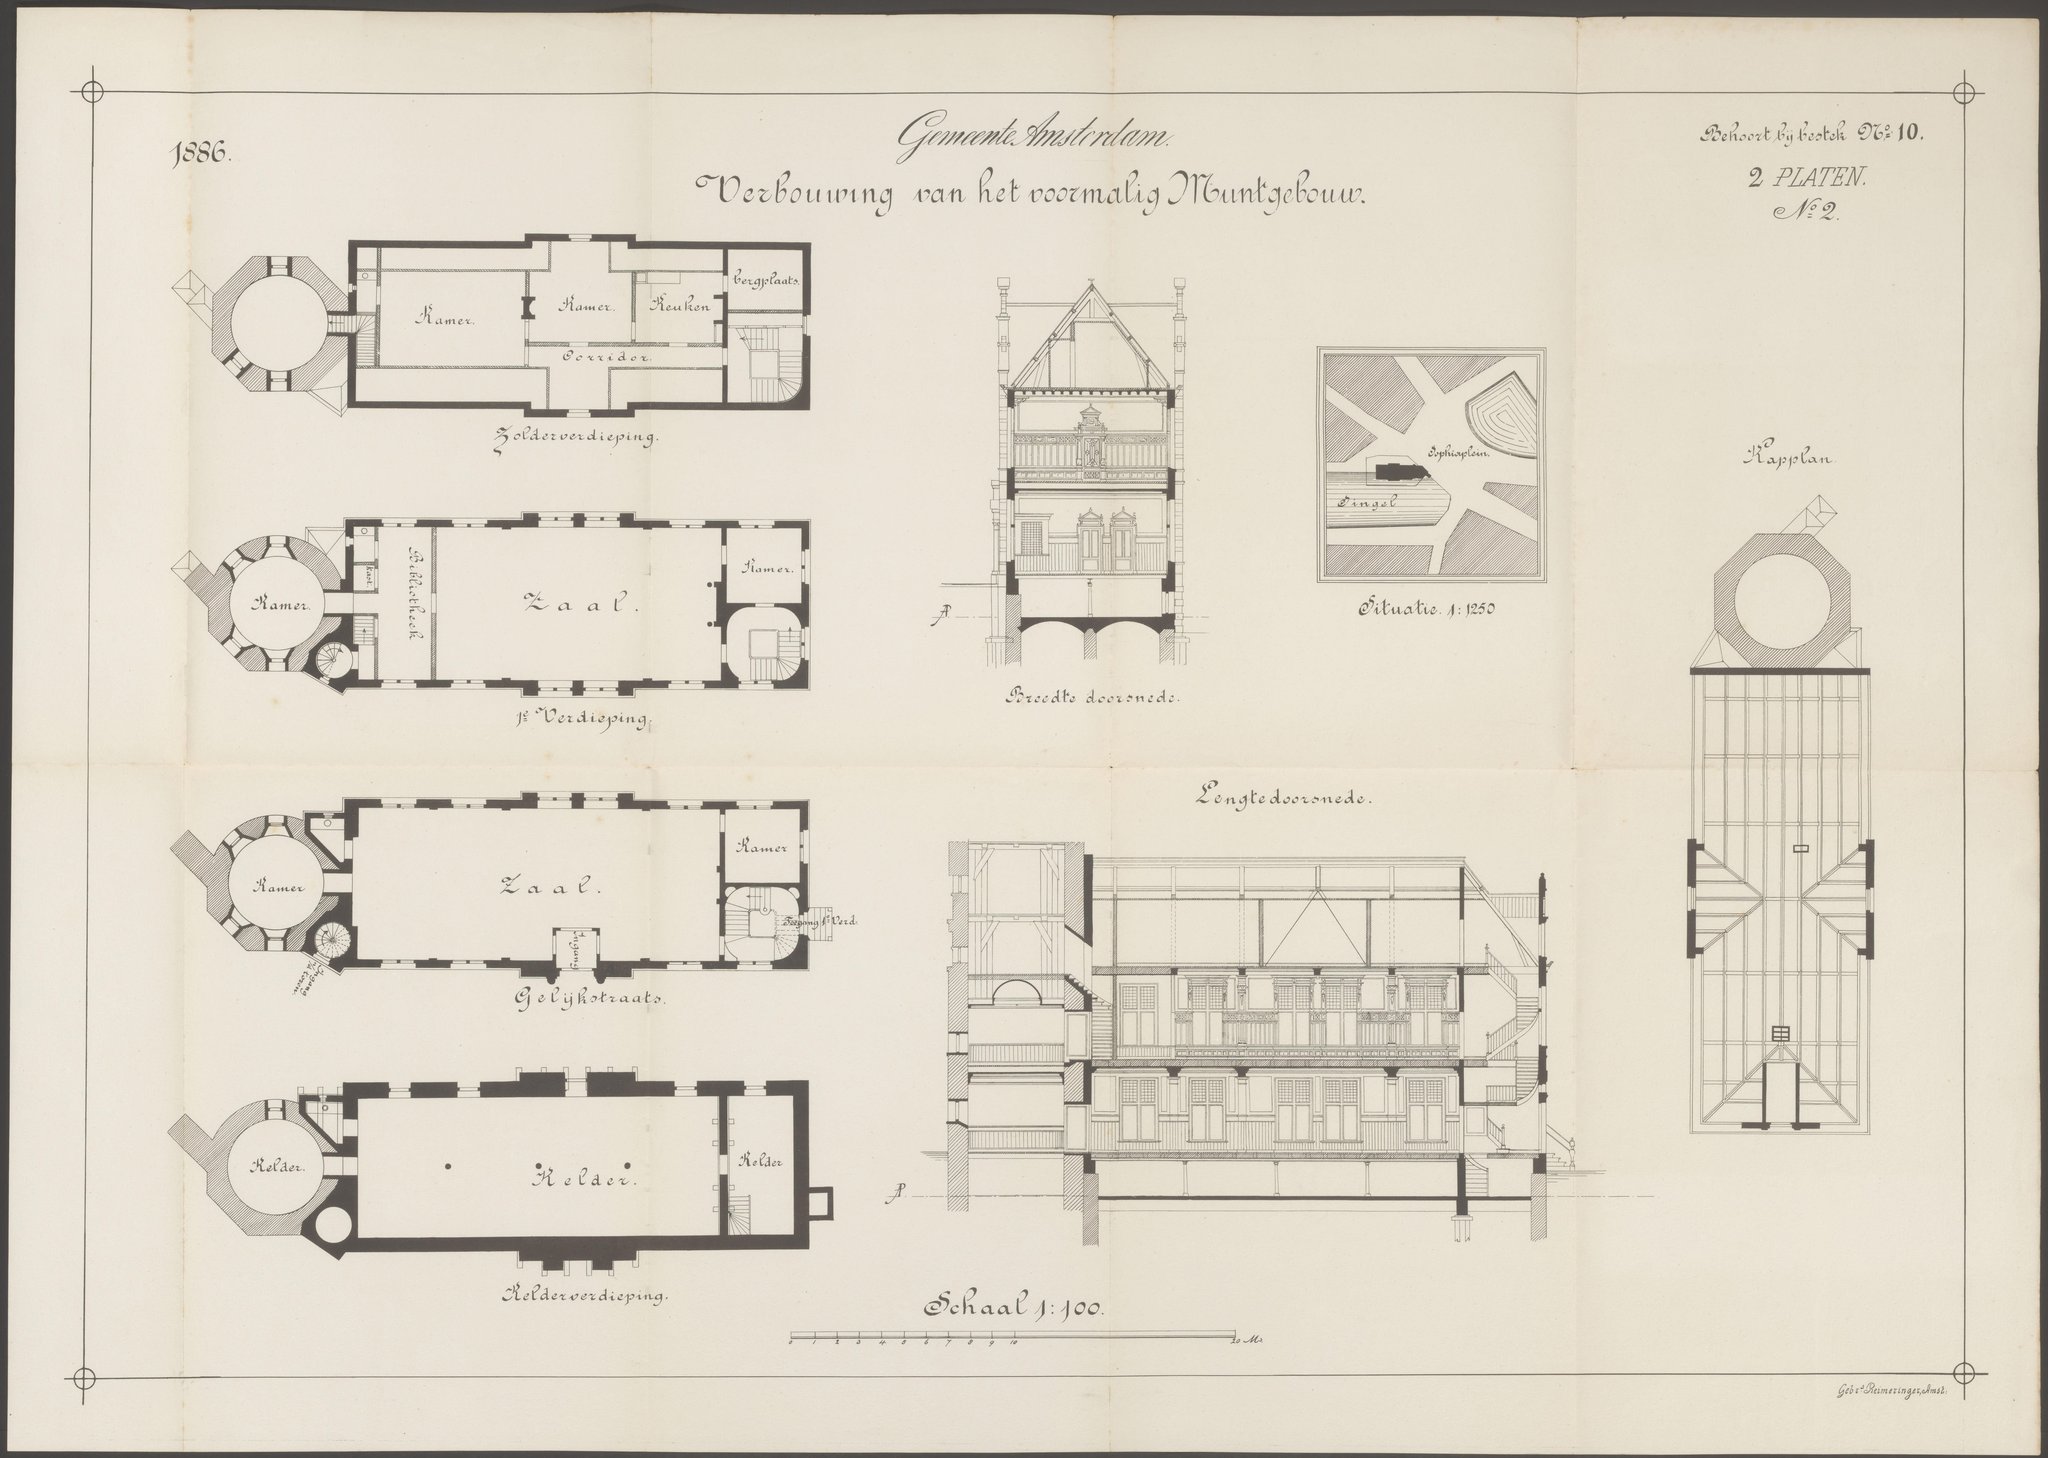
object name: area plan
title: Bestek No. 10 / 2 platen / Verbouwing van het voormalig Muntgebouw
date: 1886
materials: paper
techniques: letterpress printing, lithograph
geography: amsterdam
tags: floor plan ~ architectural design or model, plan ~ architecture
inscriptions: signature: ‘AP (?)’, collector's mark: Lugt 1641b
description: Onderwerpsrubriek binnen de Atlas Amsterdam: Reguliers- of Munttoren.